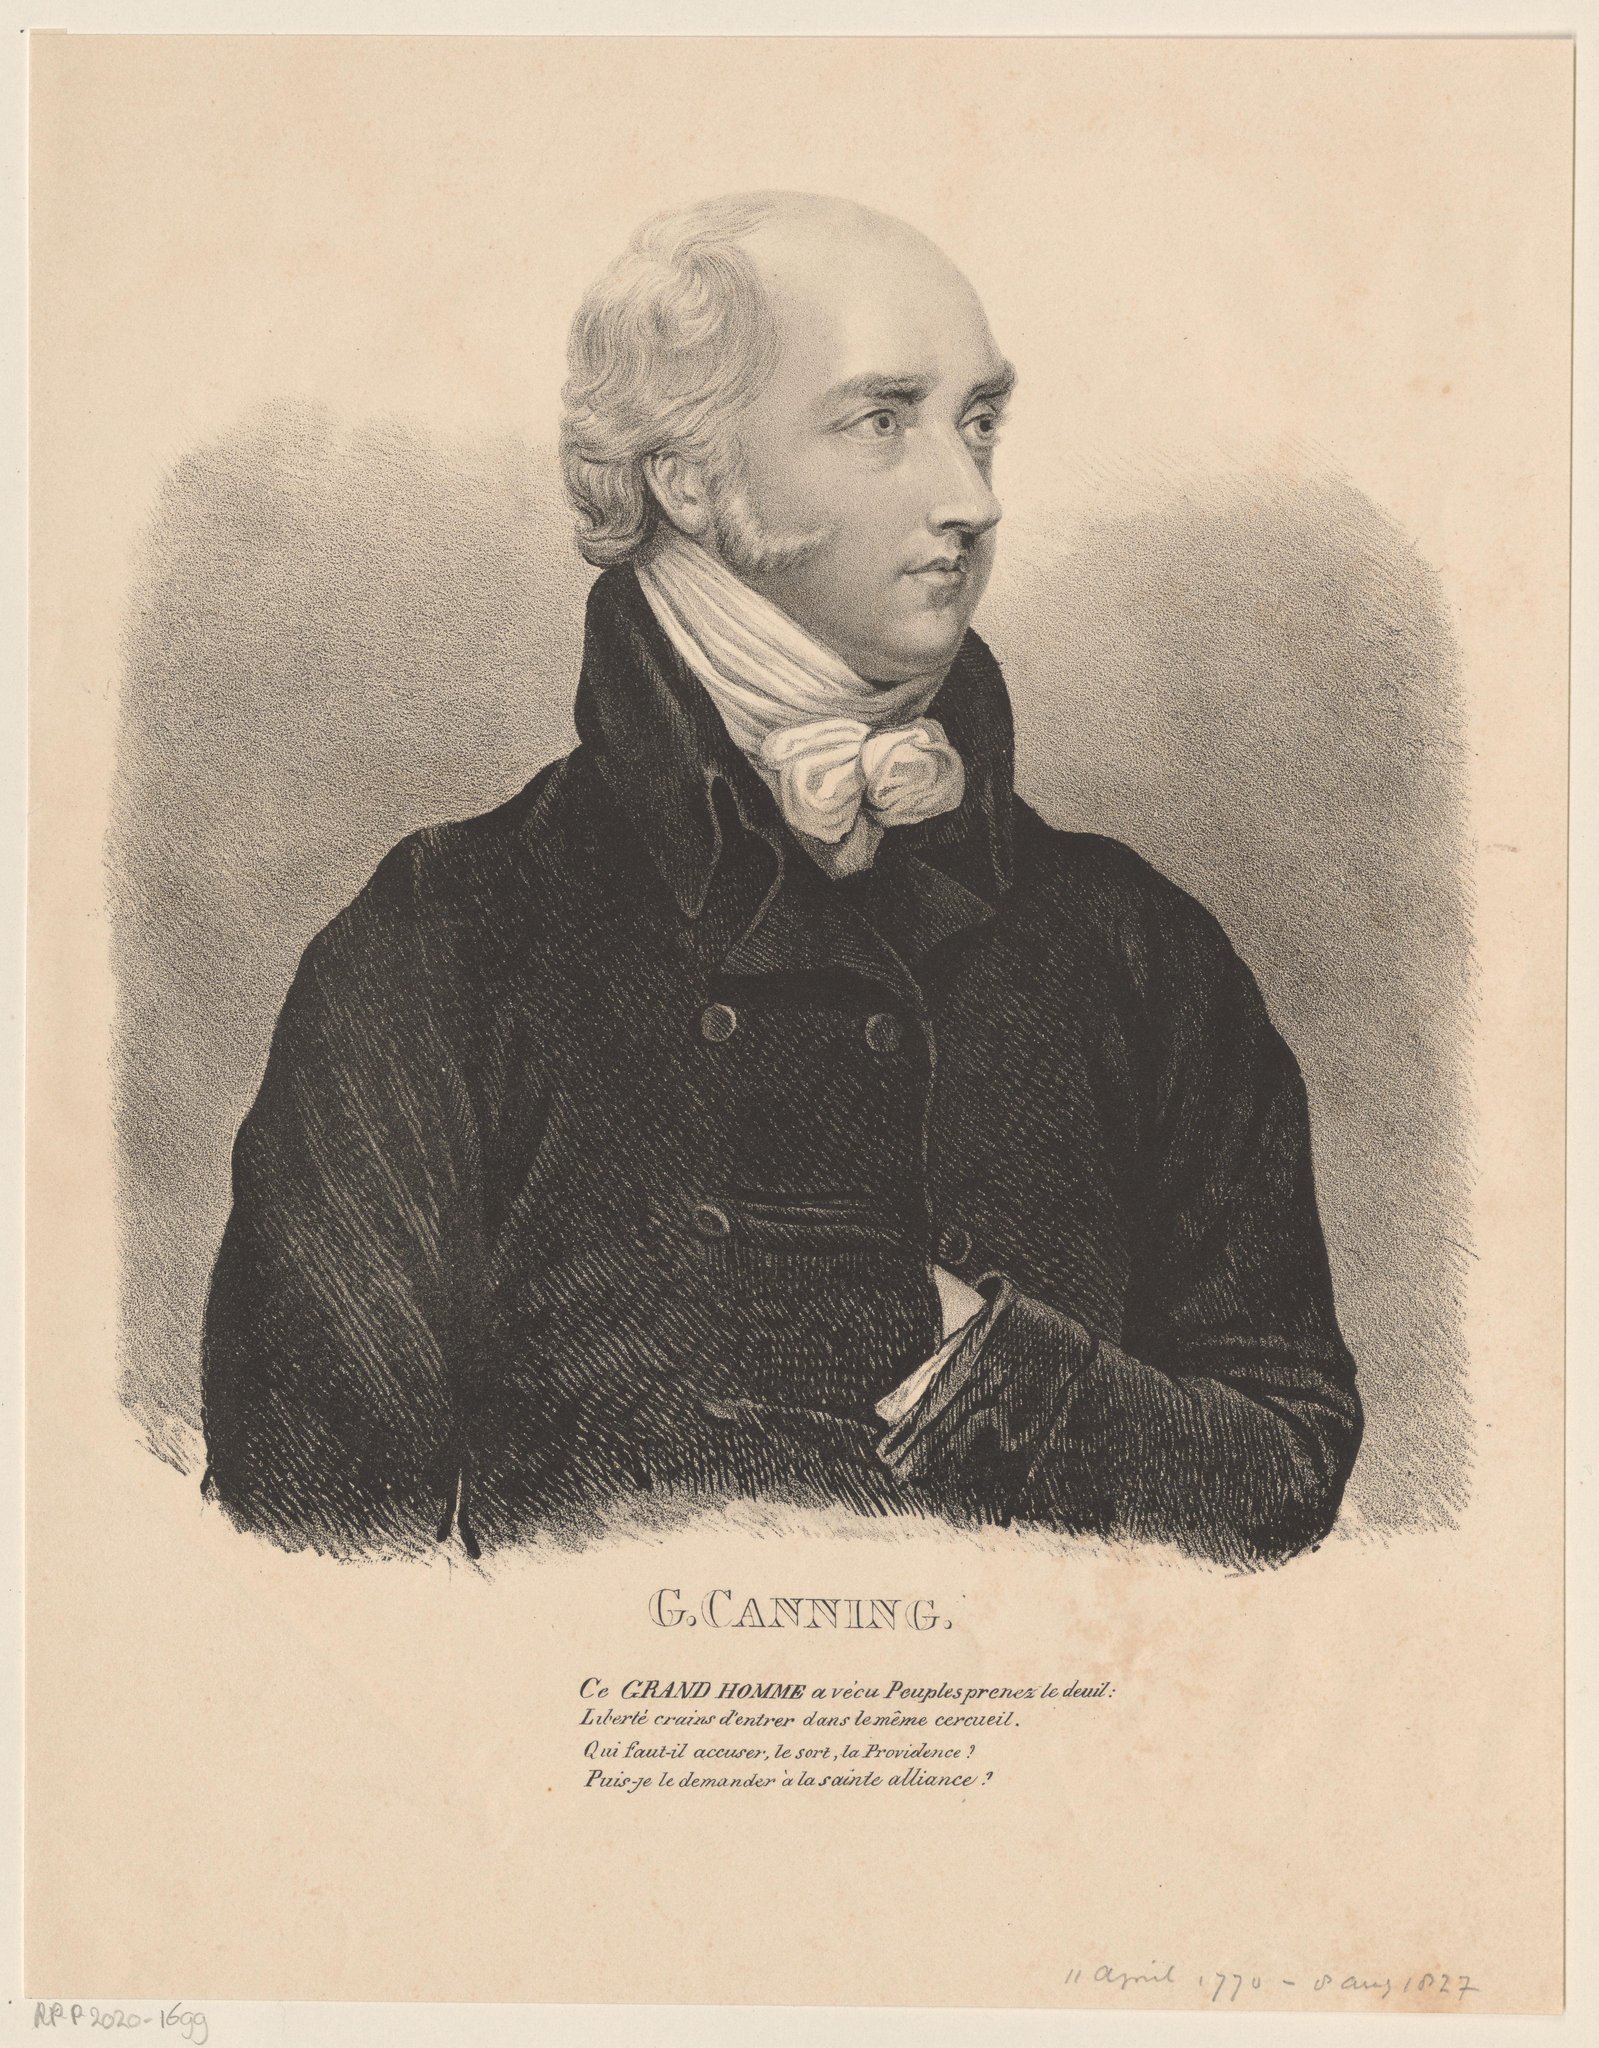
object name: print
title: Portret van George Canning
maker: Anonymous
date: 1795-1828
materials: paper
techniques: lithograph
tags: london, historical persons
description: Prent vermeld in: Lesueur-Destourets, P. Revue politique et religieuse au 31 décembre 1827. Brussel: Fréchet, 1828.